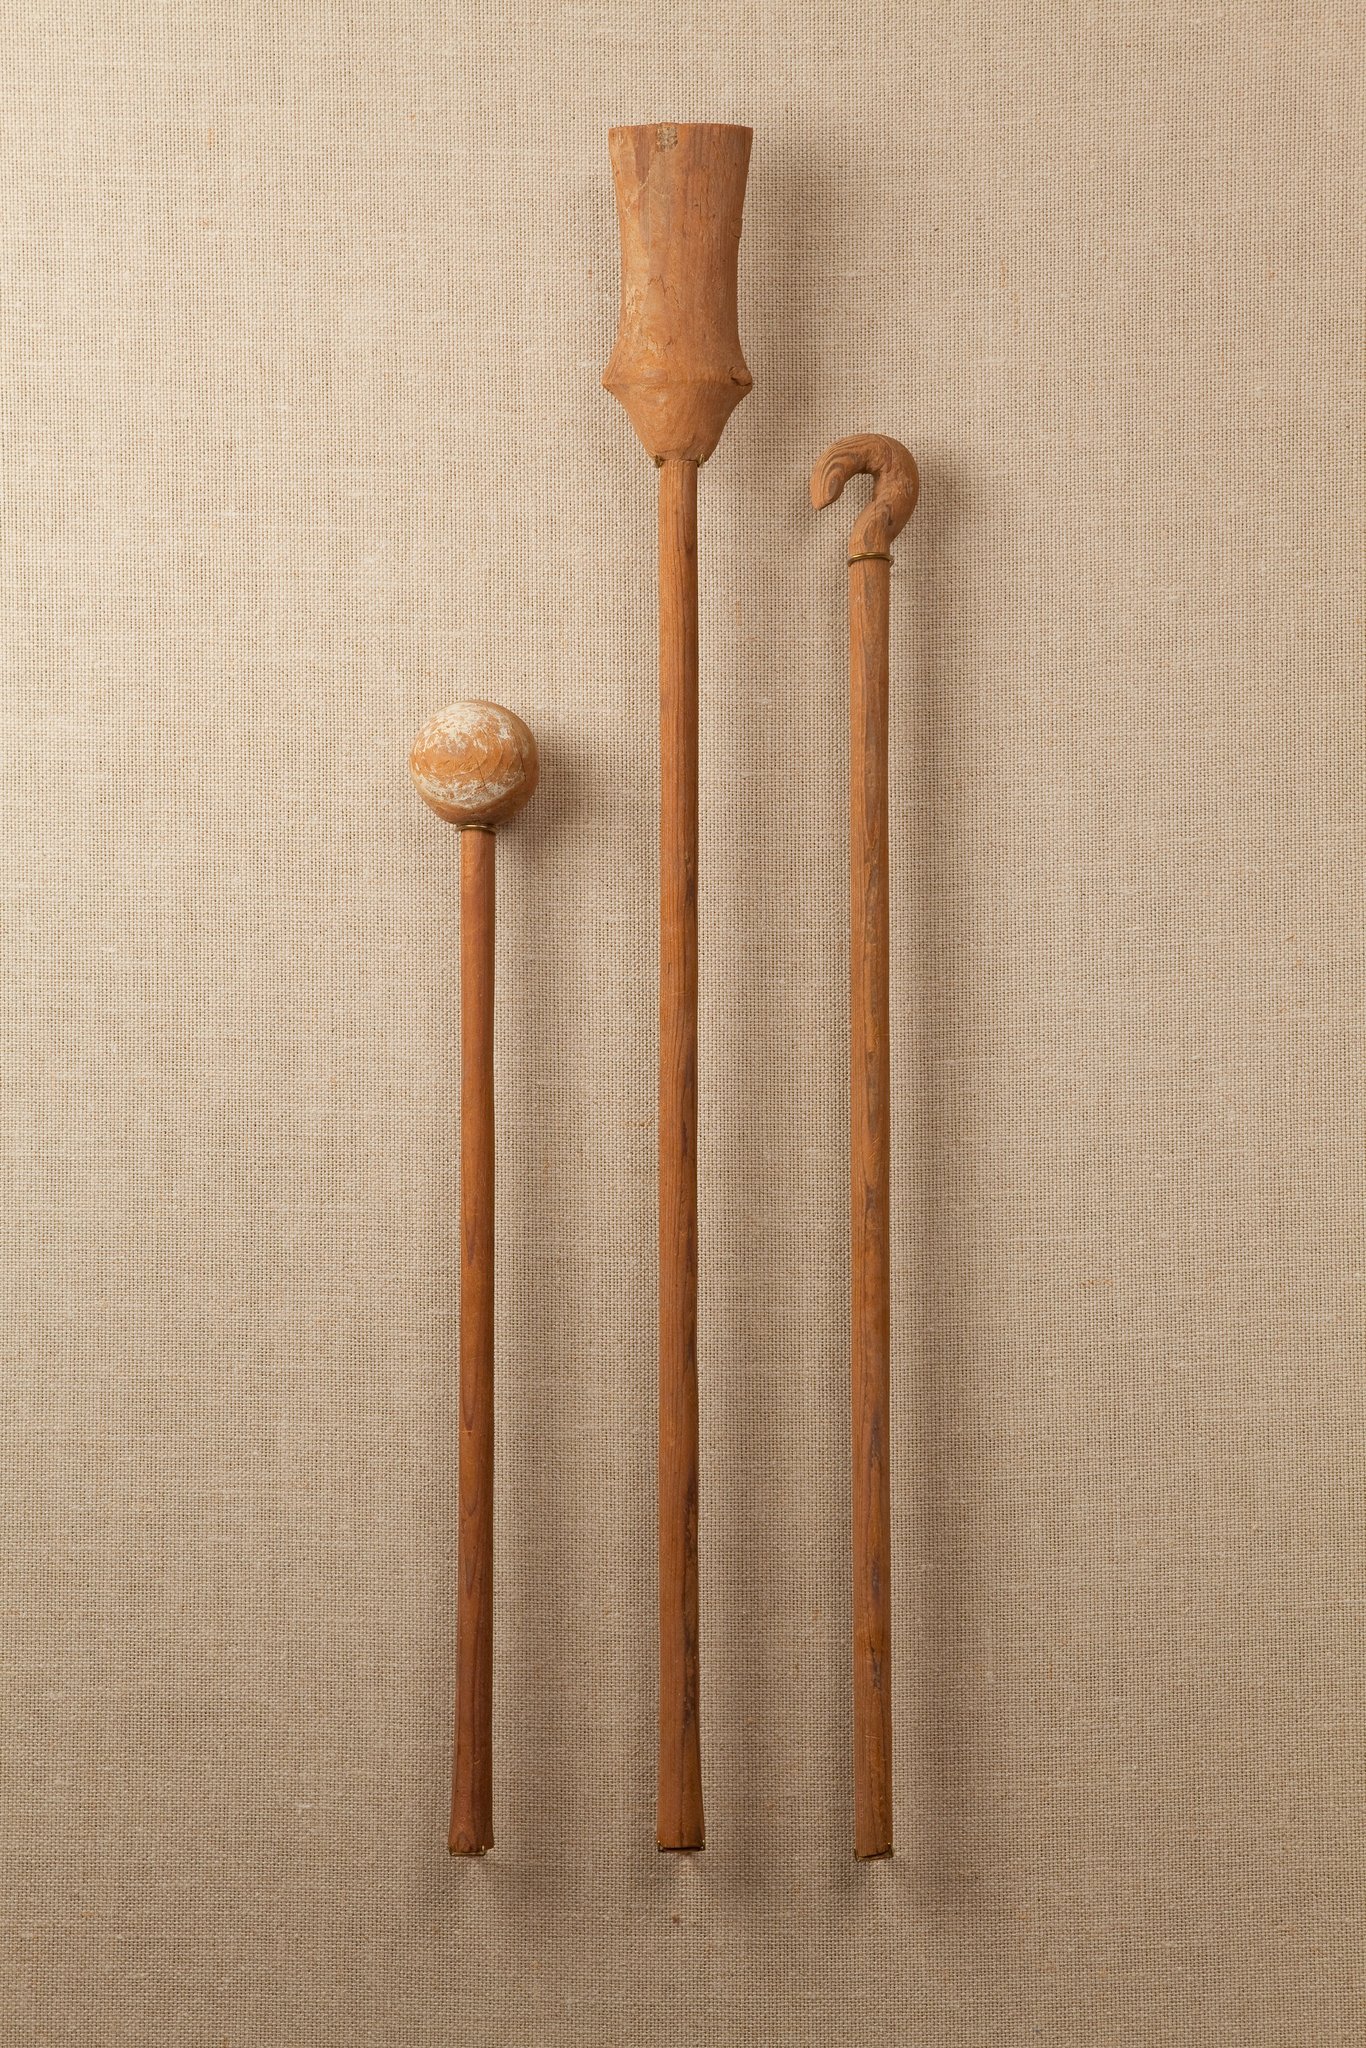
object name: model scepter, sekhem or aba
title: Model sekhem or aba scepter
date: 1981-1802 BCE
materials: wood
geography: egypt